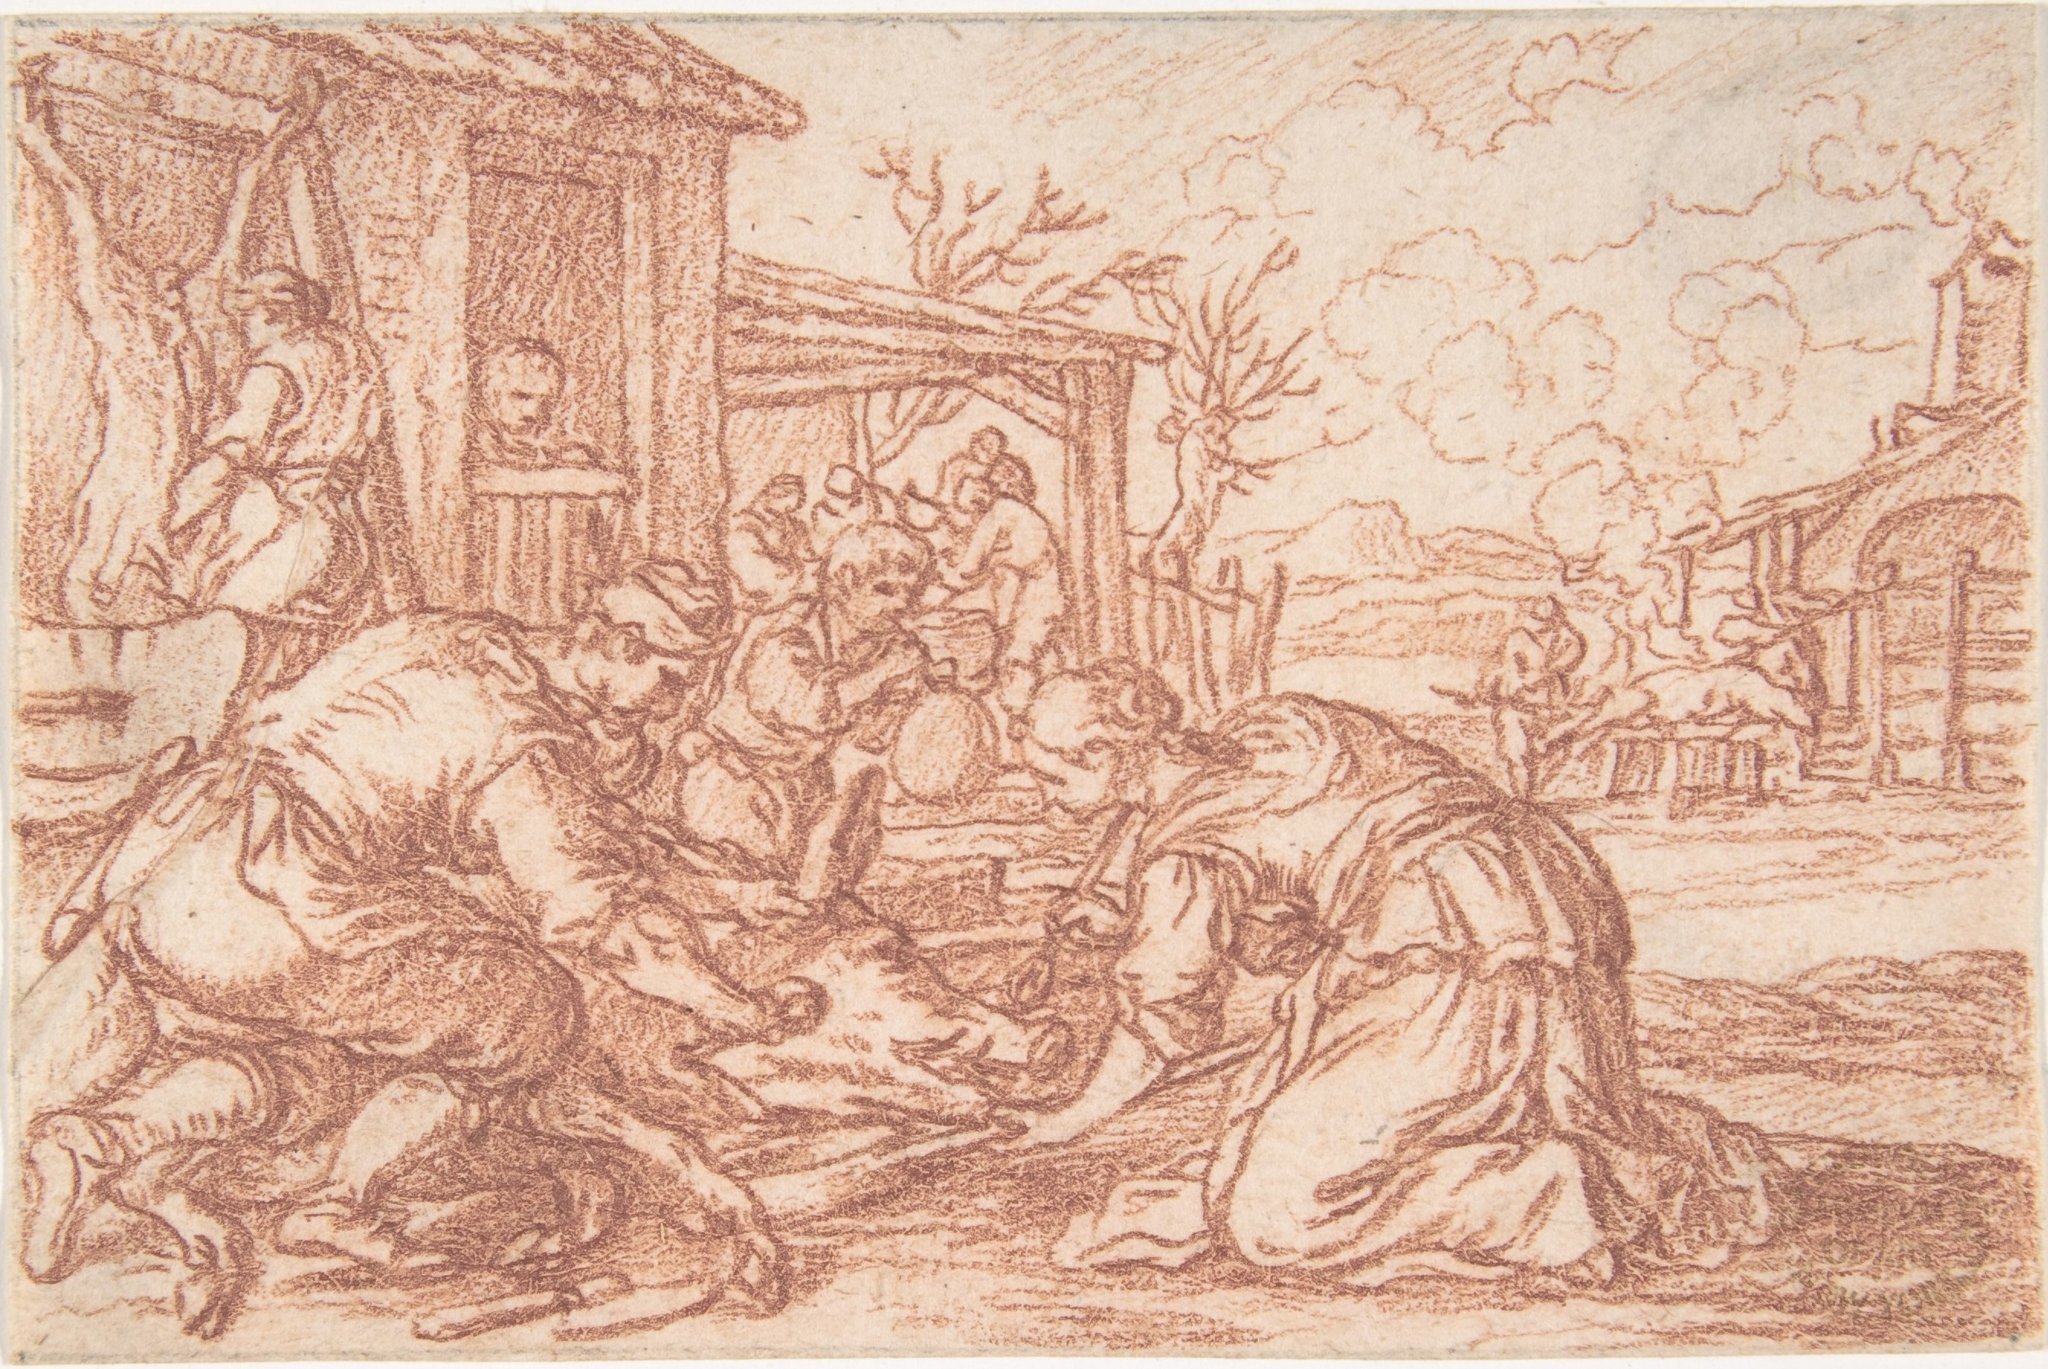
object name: drawing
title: December (one of a series representing the labors of the months)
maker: jonas umbach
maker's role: artist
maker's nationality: german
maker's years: 1624-1693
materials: chalk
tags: animals,houses,men,women